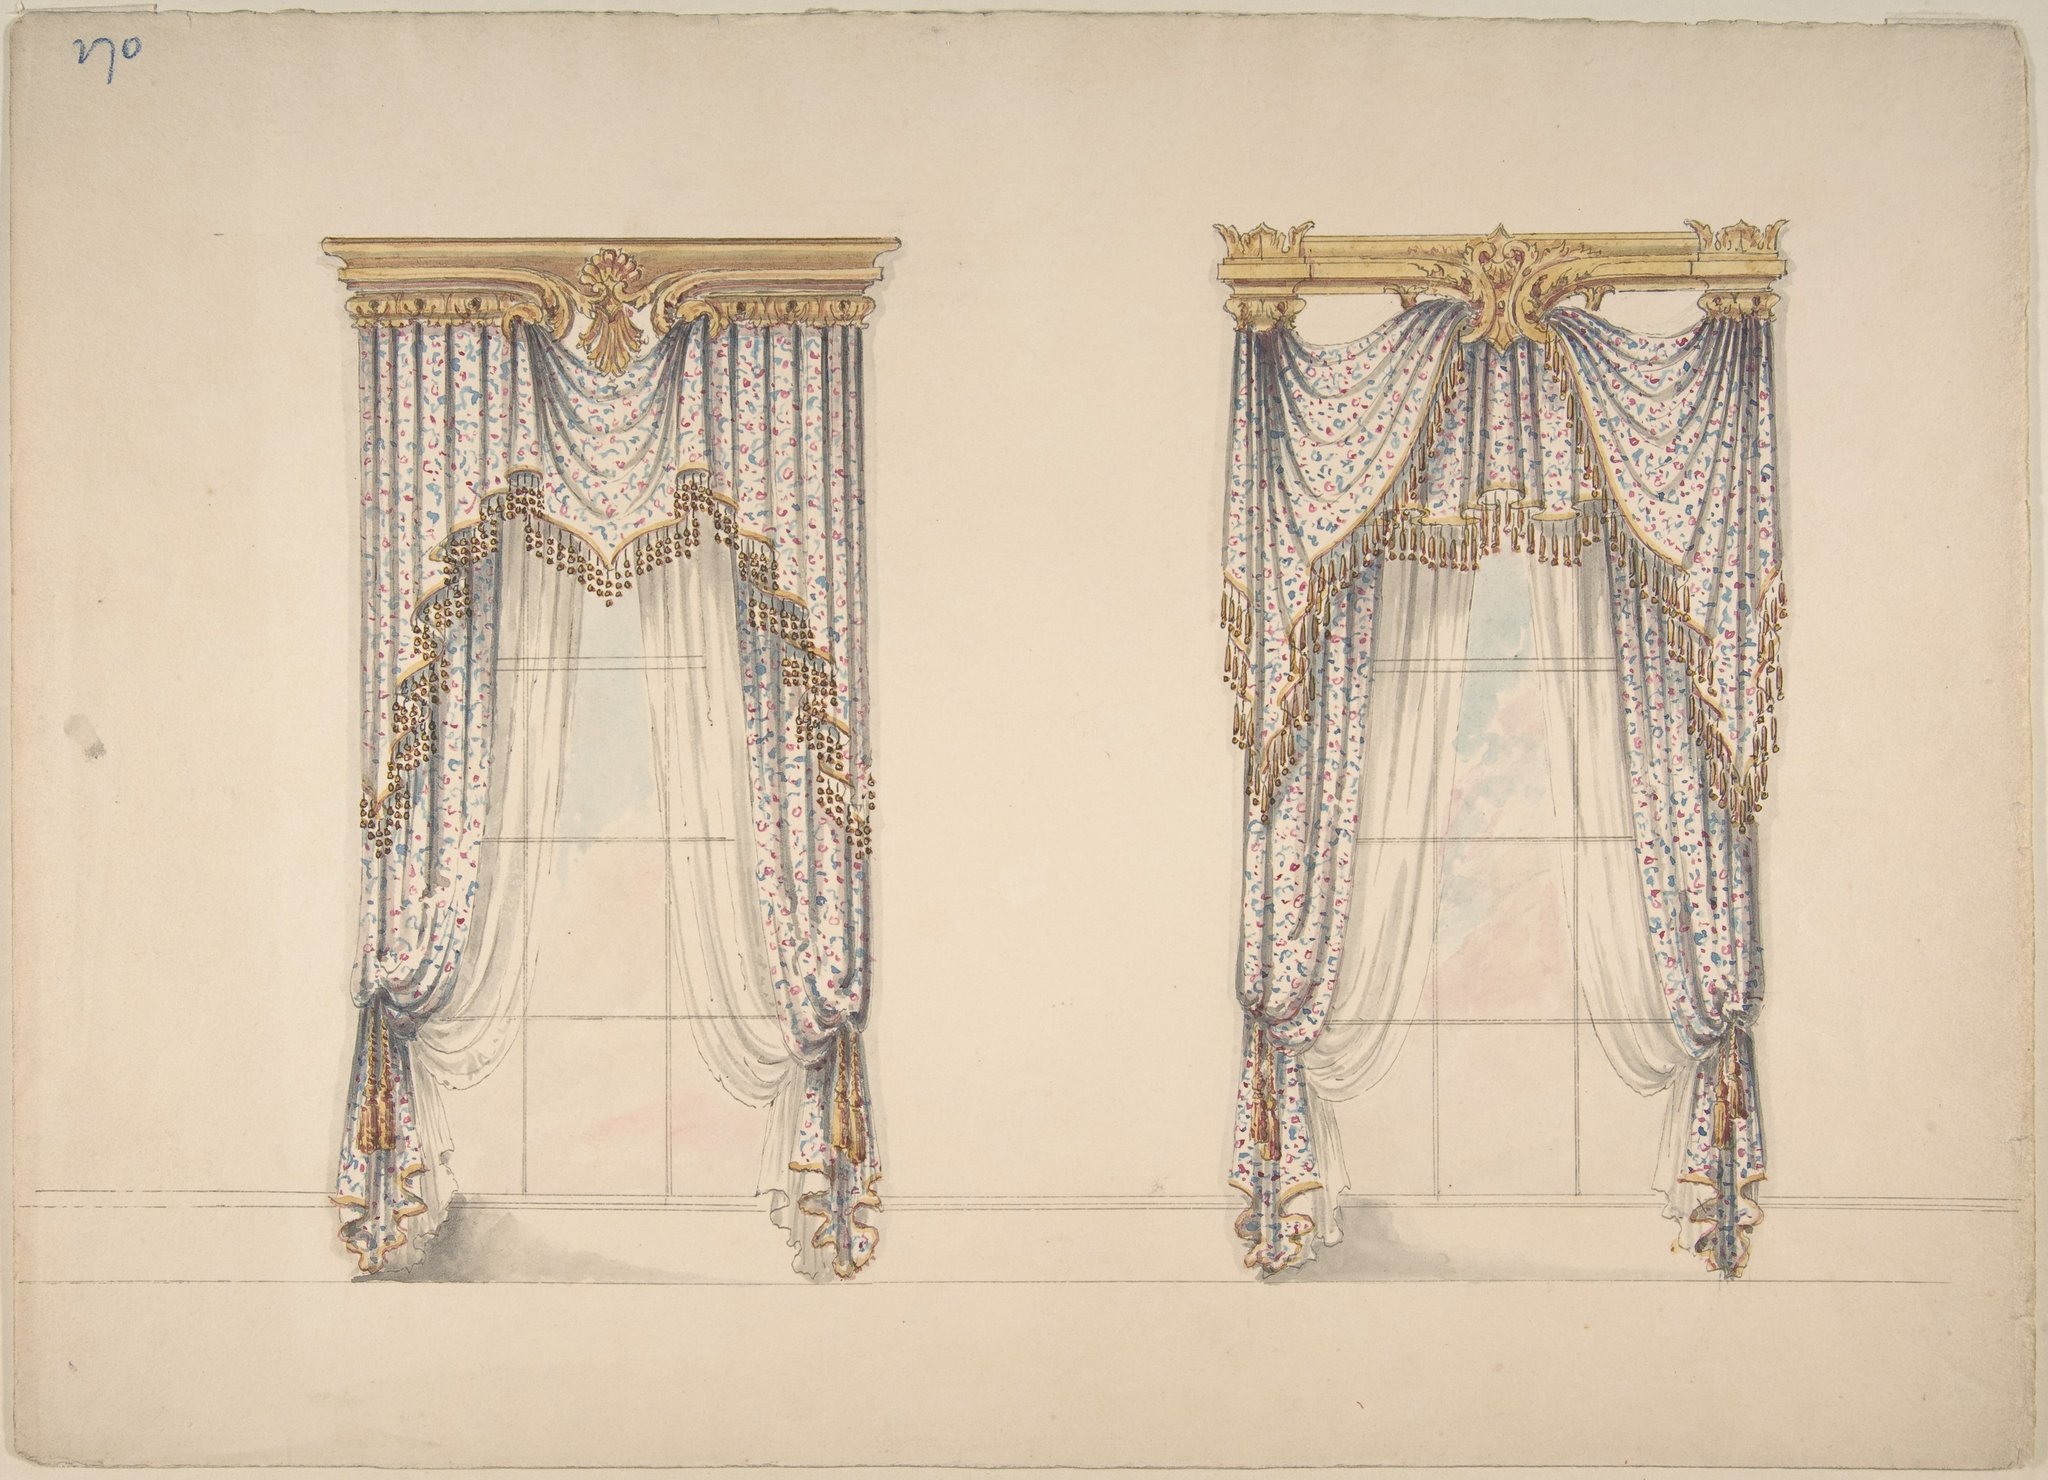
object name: drawing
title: Design for Pink, Green and White Curtains with Gold and Red Fringes, and Gold Pediments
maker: anonymous, british, 19th century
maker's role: artist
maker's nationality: british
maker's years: 1800-1900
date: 1820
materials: ink, watercolor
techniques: brush, pen, wash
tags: windows,curtains